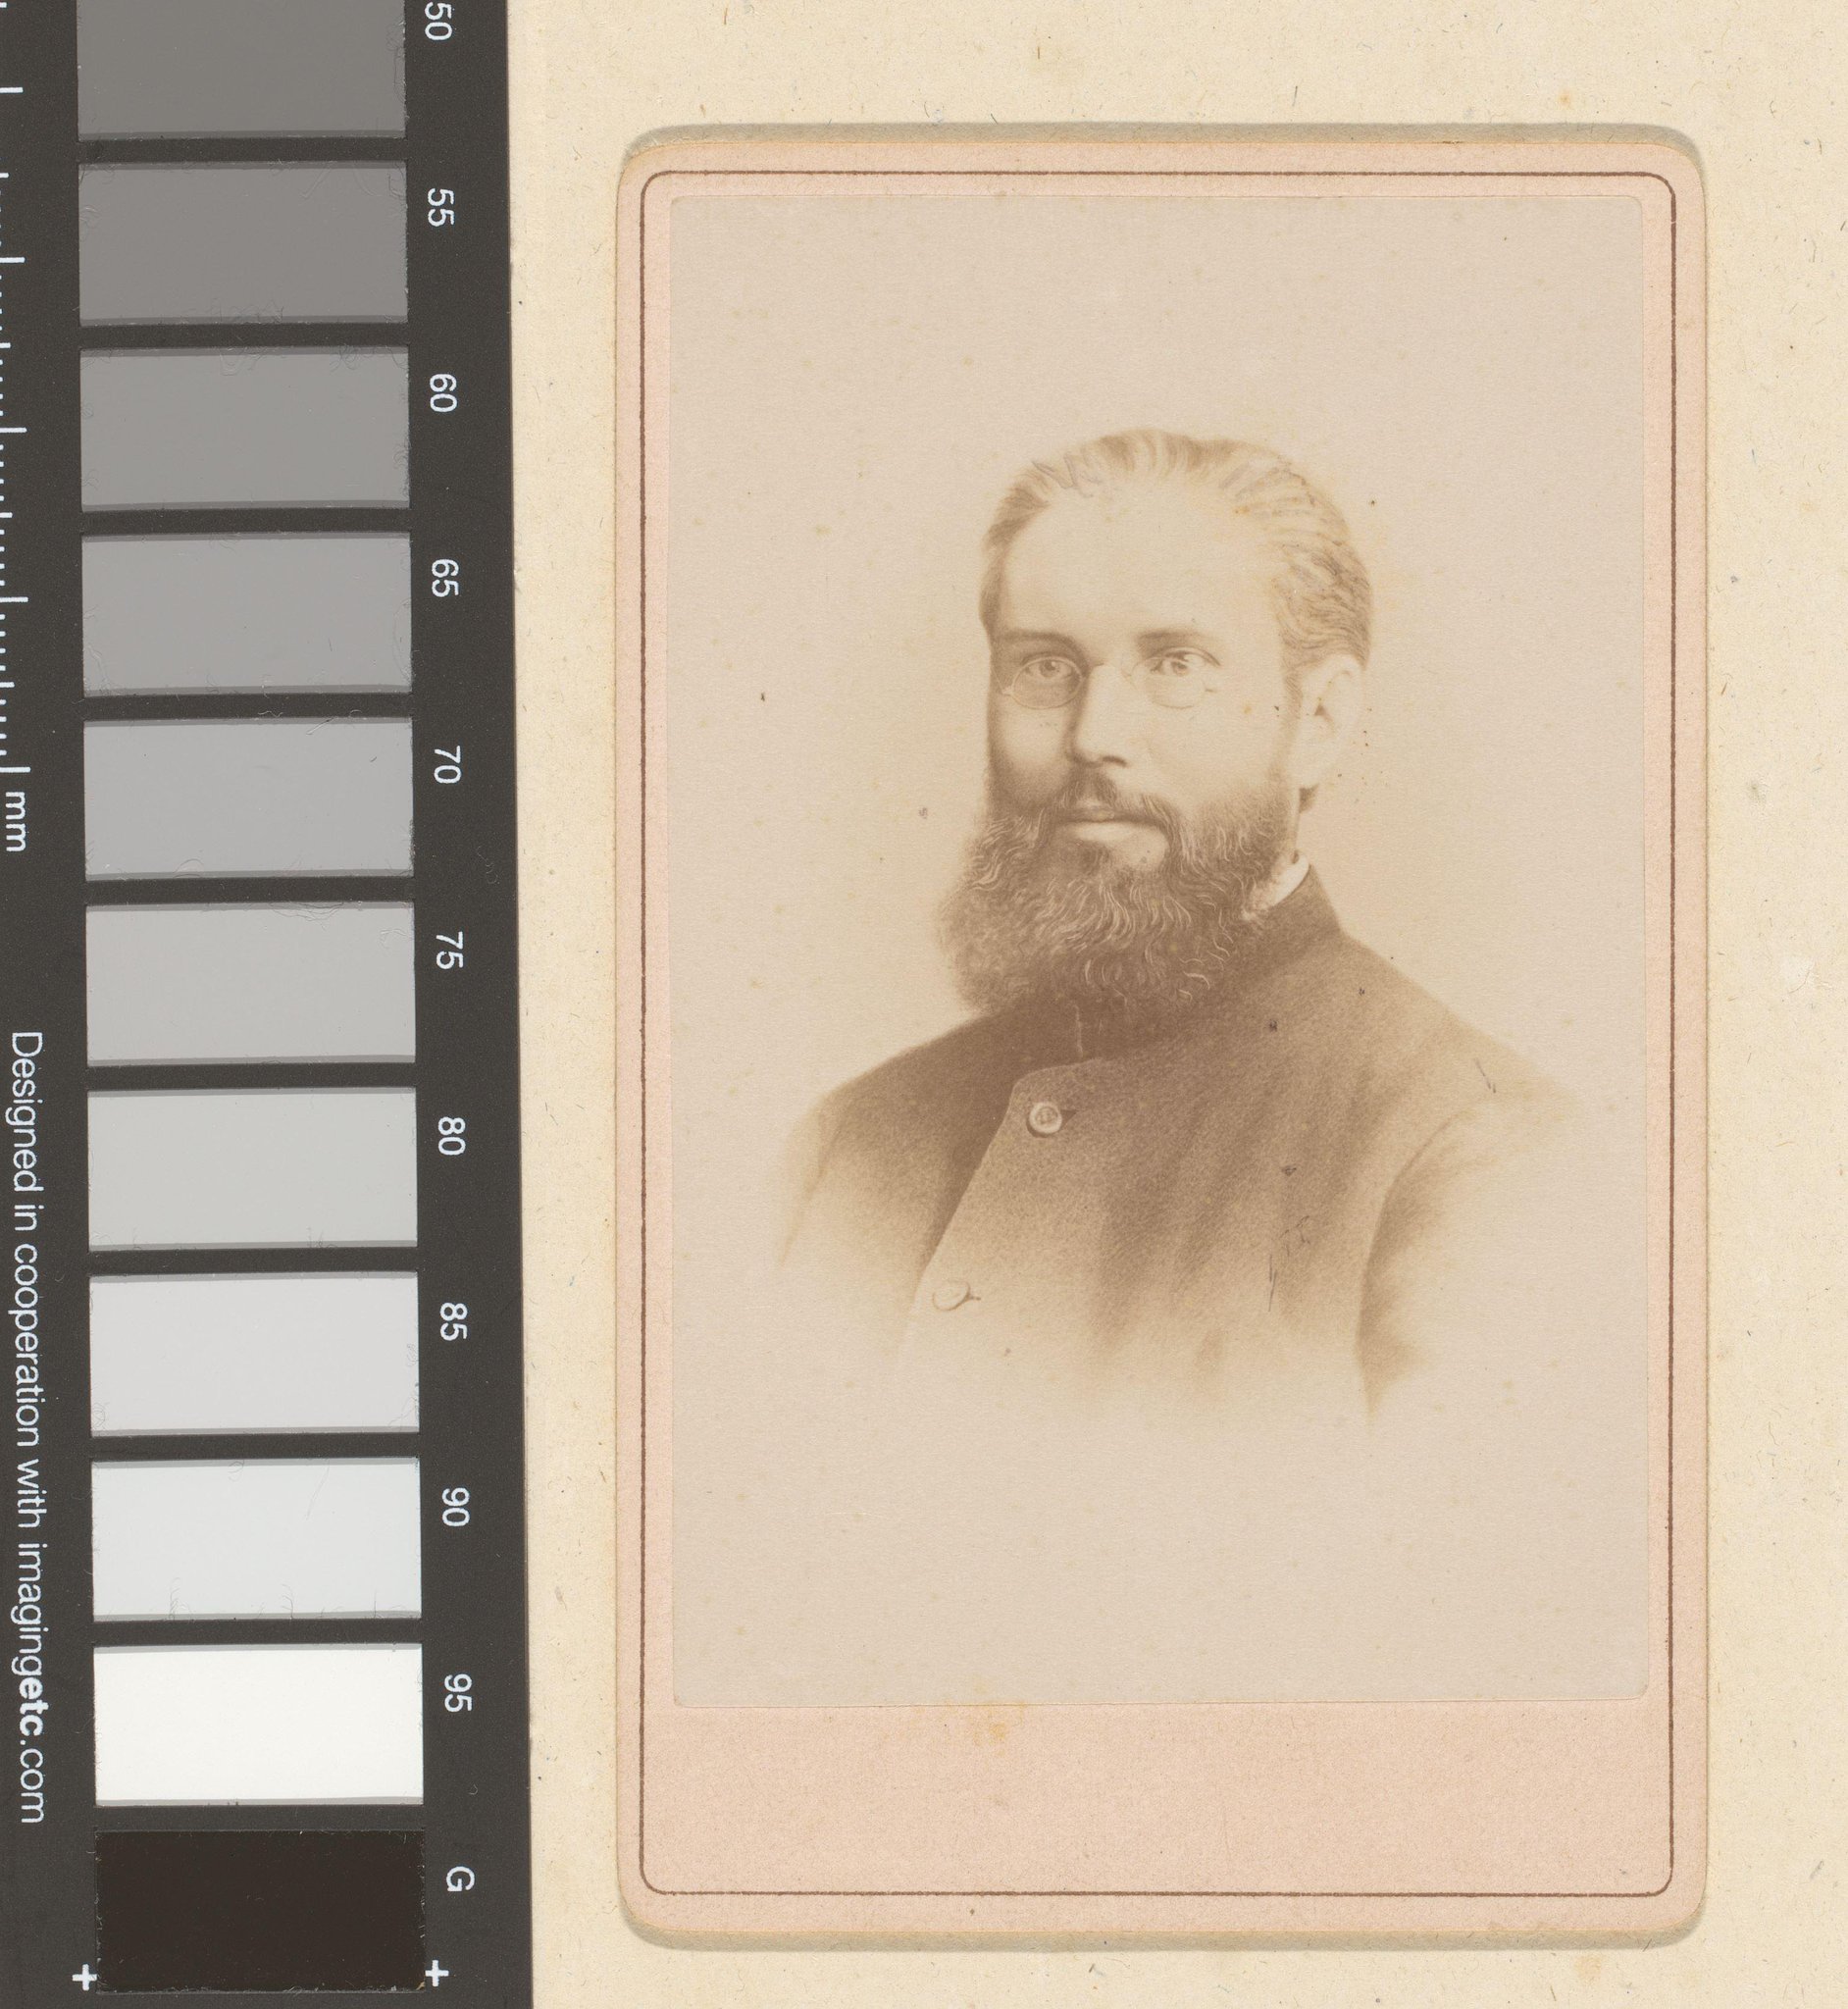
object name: photograph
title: Portret van professor H.R. Ranke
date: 1860-1864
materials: paper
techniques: albumen print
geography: utrecht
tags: historical persons (portraits and scenes from the life)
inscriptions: annotation: ‘H.R. Ranke Chem. Professor te Groningen 1878-1887’